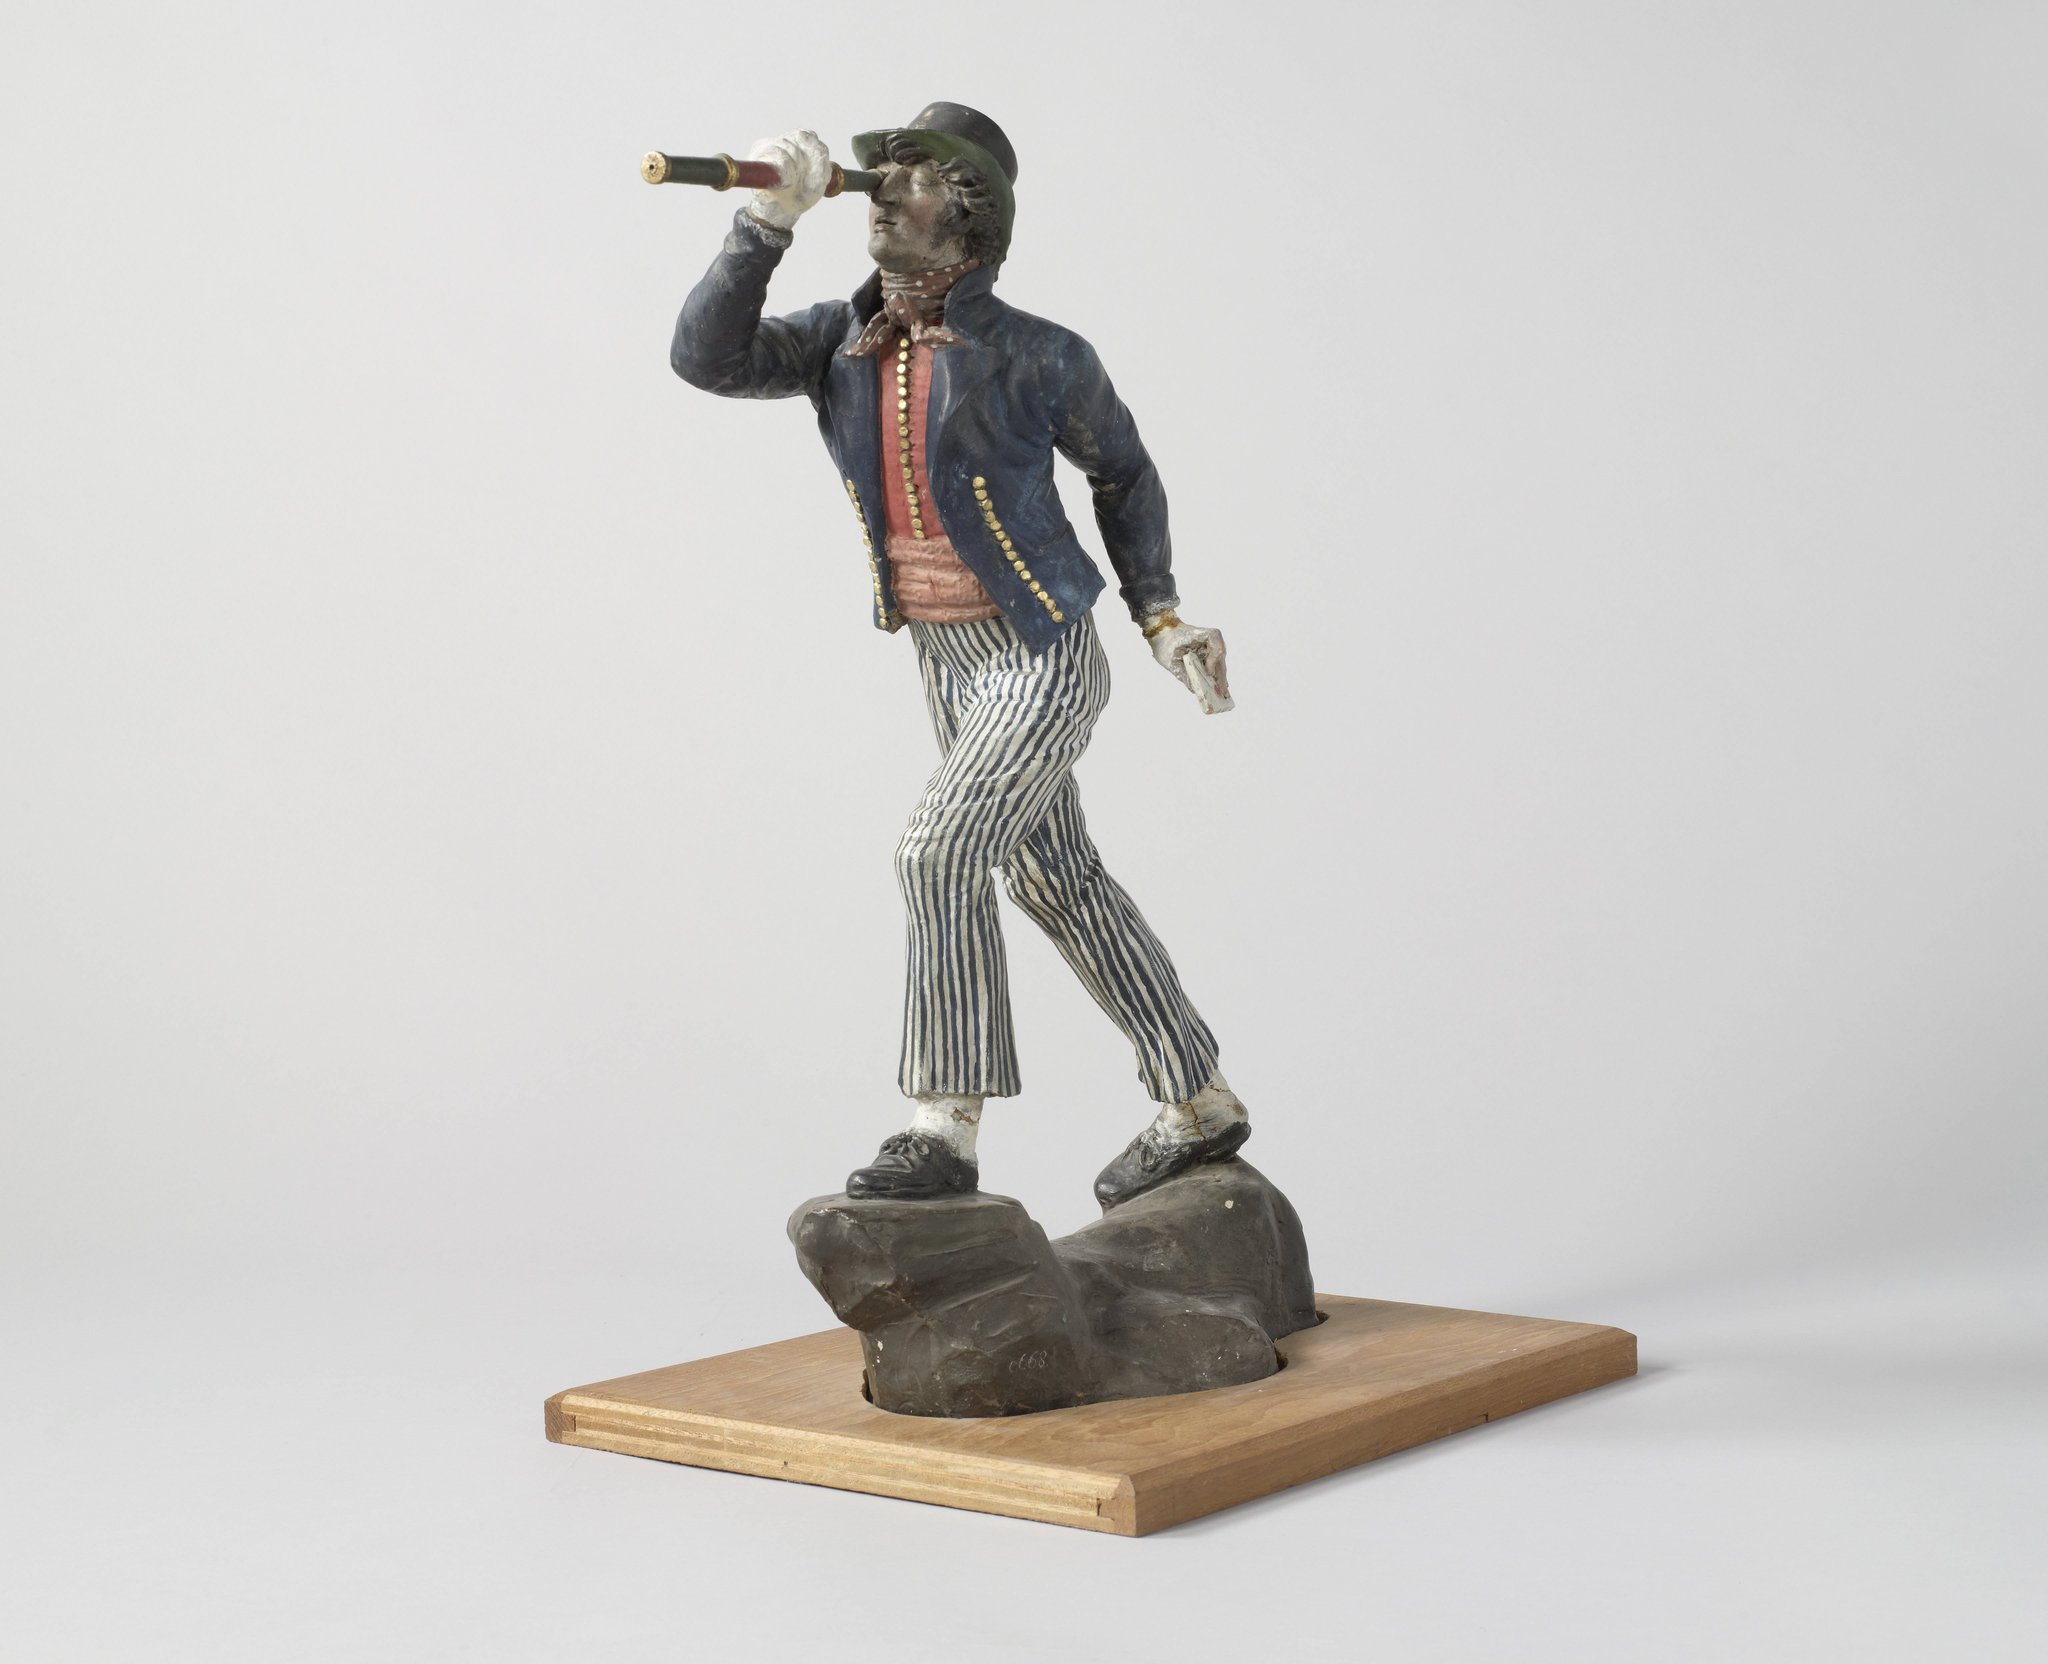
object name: model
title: Model of a Figurehead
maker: Anonymous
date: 1800-1805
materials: terracotta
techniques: polychromy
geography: netherlands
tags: kapitein, schout-bij-nacht, harco hilarius hora siccama, spion (schip)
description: Het model stelt het schegbeeld voor van de brik Spion (1800-1804), gecommandeerd door de kapitein-luitenant-ter-zee Harco Hilarius Hora Siccama, grootvader van de schenkers.